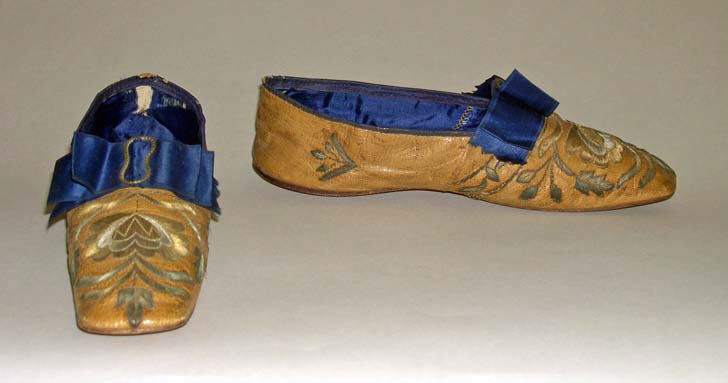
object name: slipper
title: Slippers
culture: american or european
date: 1850-1859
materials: leather